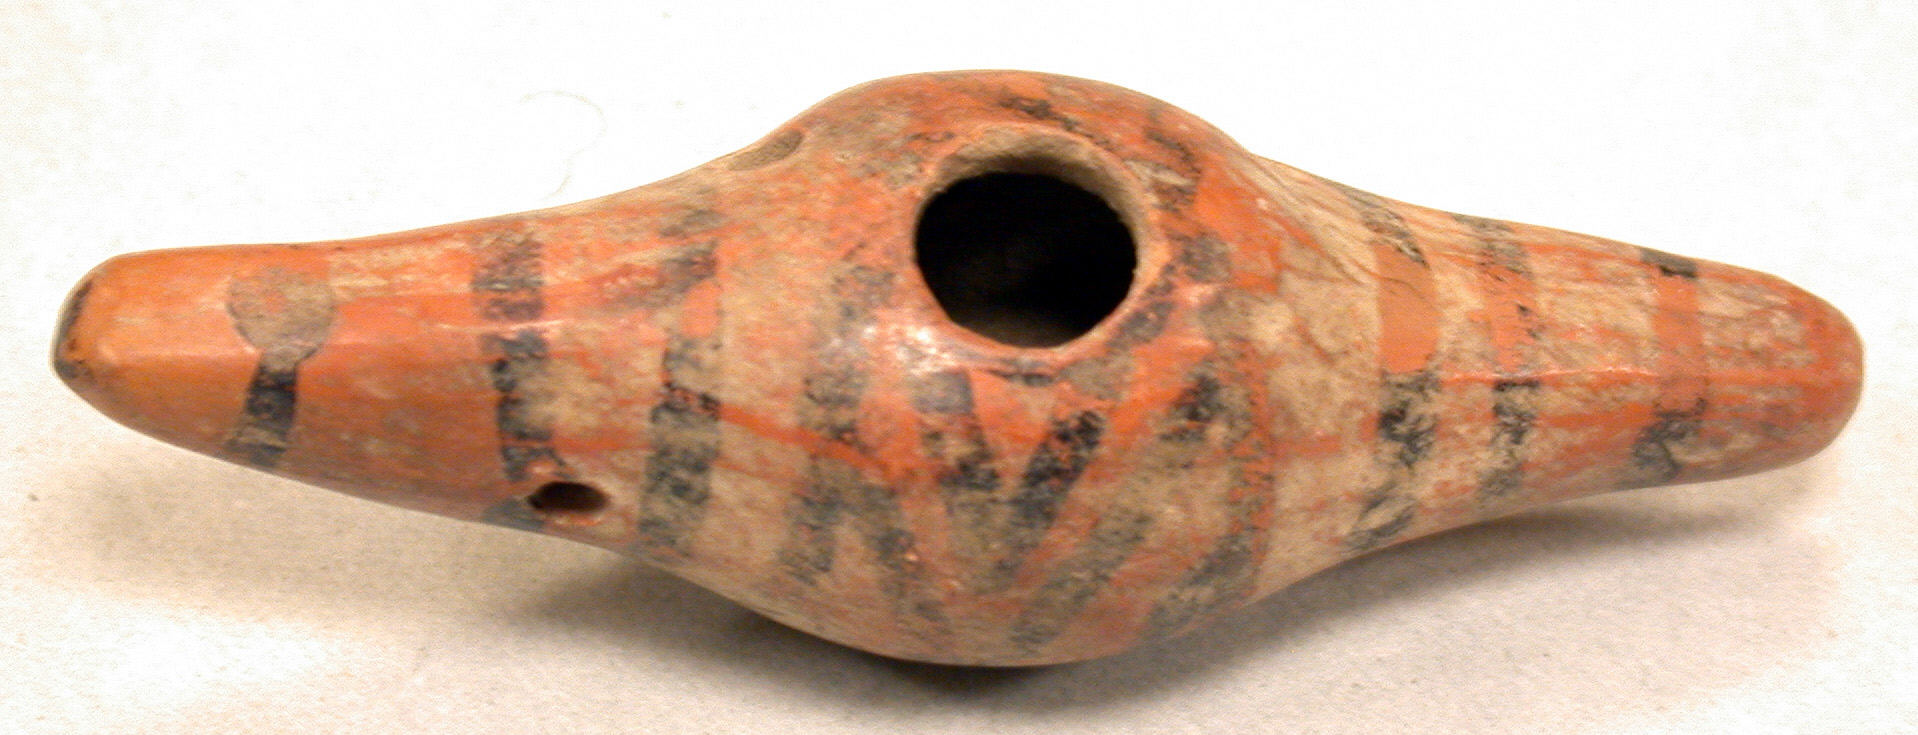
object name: whistle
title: Pod-Shaped Whistle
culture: peruvian, north or central coast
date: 300-1000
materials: ceramic, pigment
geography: peru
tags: musical instruments